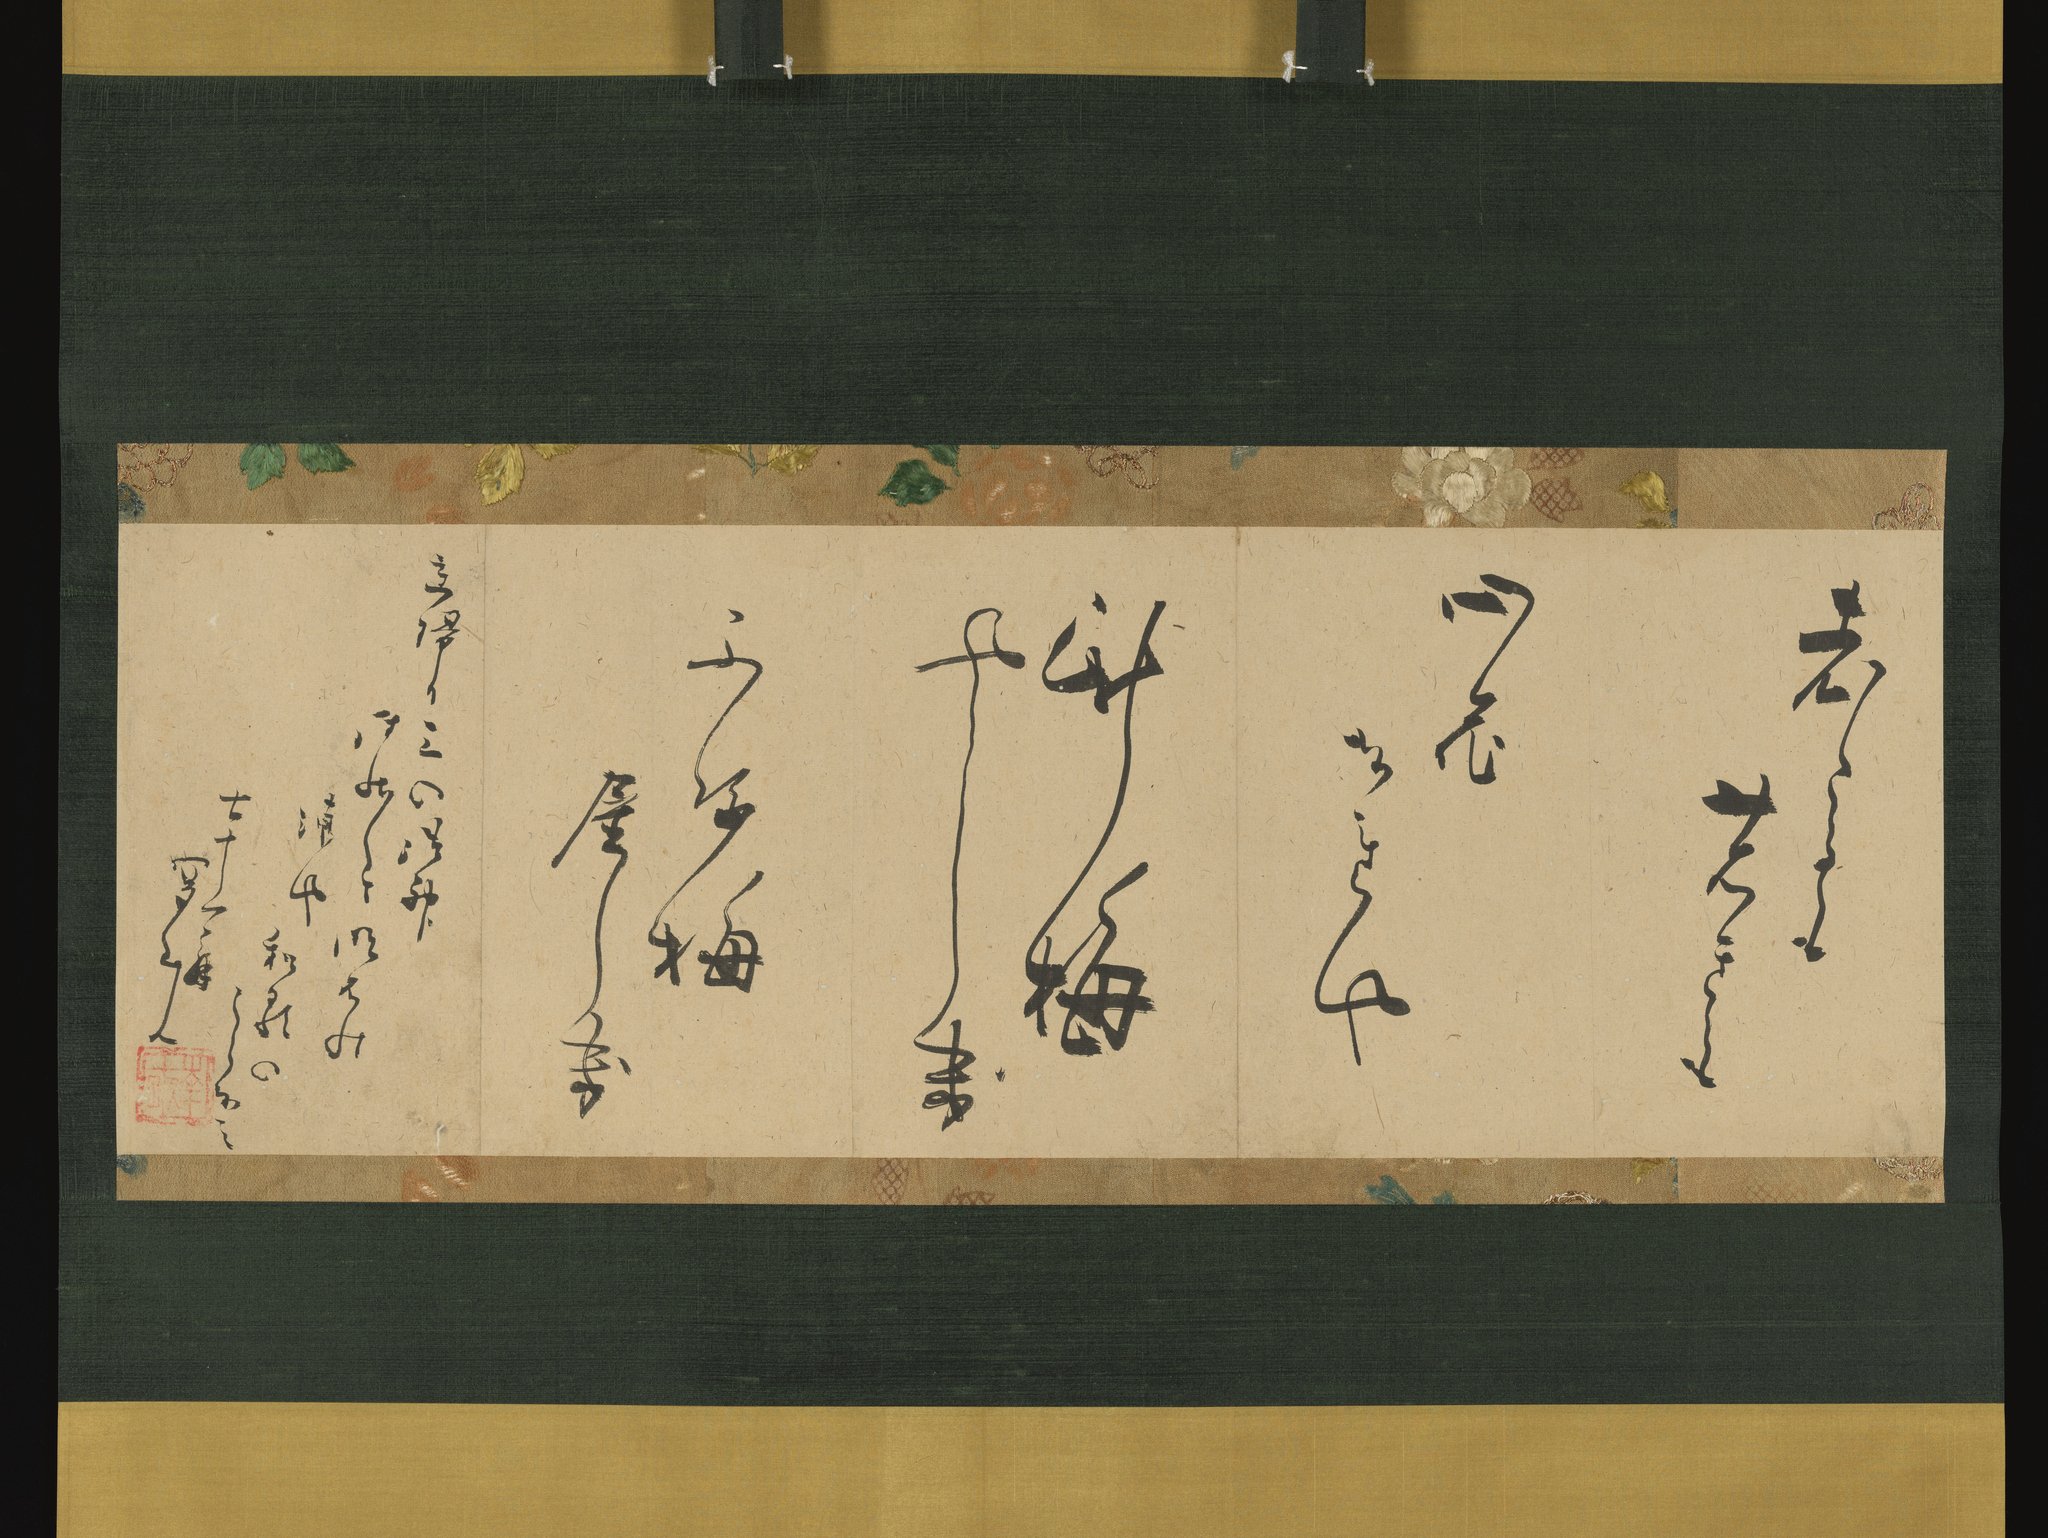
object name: hanging scroll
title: Two Kyōka (Playful Thirty-One- Syllable Verse)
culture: japanese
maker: shokusanjin (ōta nanpo)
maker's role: artist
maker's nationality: japanese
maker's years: 1749-1823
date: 1819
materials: ink, paper